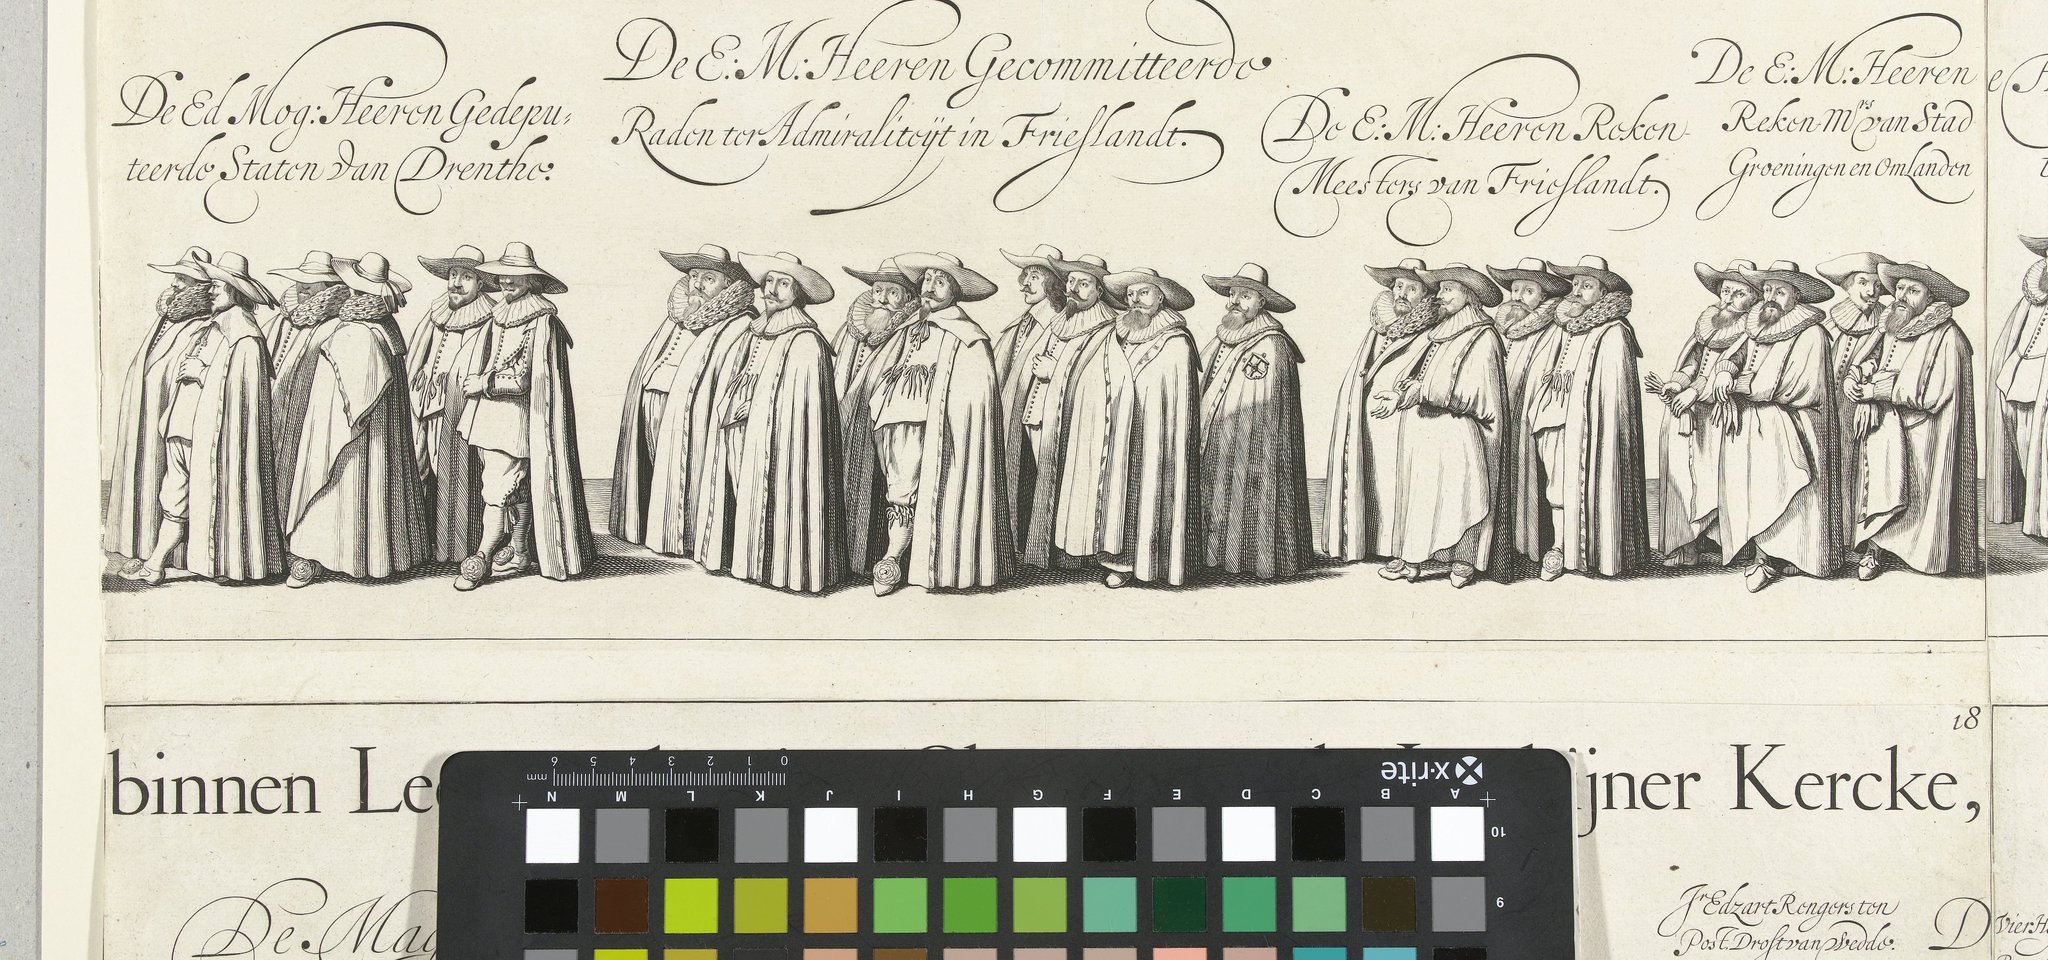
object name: print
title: Treur-Statighe Uyt-Vaert, ofte Begraeffenisse des ont-zielden Lichaems, van den On-vertsaeghden, ende seer Strijdtbaren Krijghs-Heldt, Ernest Casimyr (...) Overleden in de Belegheringhe voor Roermunde, door een Vyandtlijcke Koeghel (...) den vijff-en-twintichsten Maij, MDCXXXII. Begraven binnen Leeuwarden in 't Choor van de Iacobijner Kercke, den derden Ianuarij, MDCXXXIII. Oude Stijl.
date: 1634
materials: paper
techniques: engraving, etching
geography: leeuwarden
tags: ernst casimir graaf van nassau-dietz, cortege, funeral procession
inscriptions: date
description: Deel van de begrafenisstoet met leden van de admiraliteit en rekenmeesters van Friesland. Bovenin de functies van de afgebeelde personen. Plaat nr. 17 in de prentserie van de begrafenis van Ernst Casimir, graaf van Nassau-Dietz te Leeuwarden, 3 januari 1633. De wapens en vaandels zijn ingekleurd. Dit blad samen met bladen 18, 19 en 20 aan elkaar geplakt.